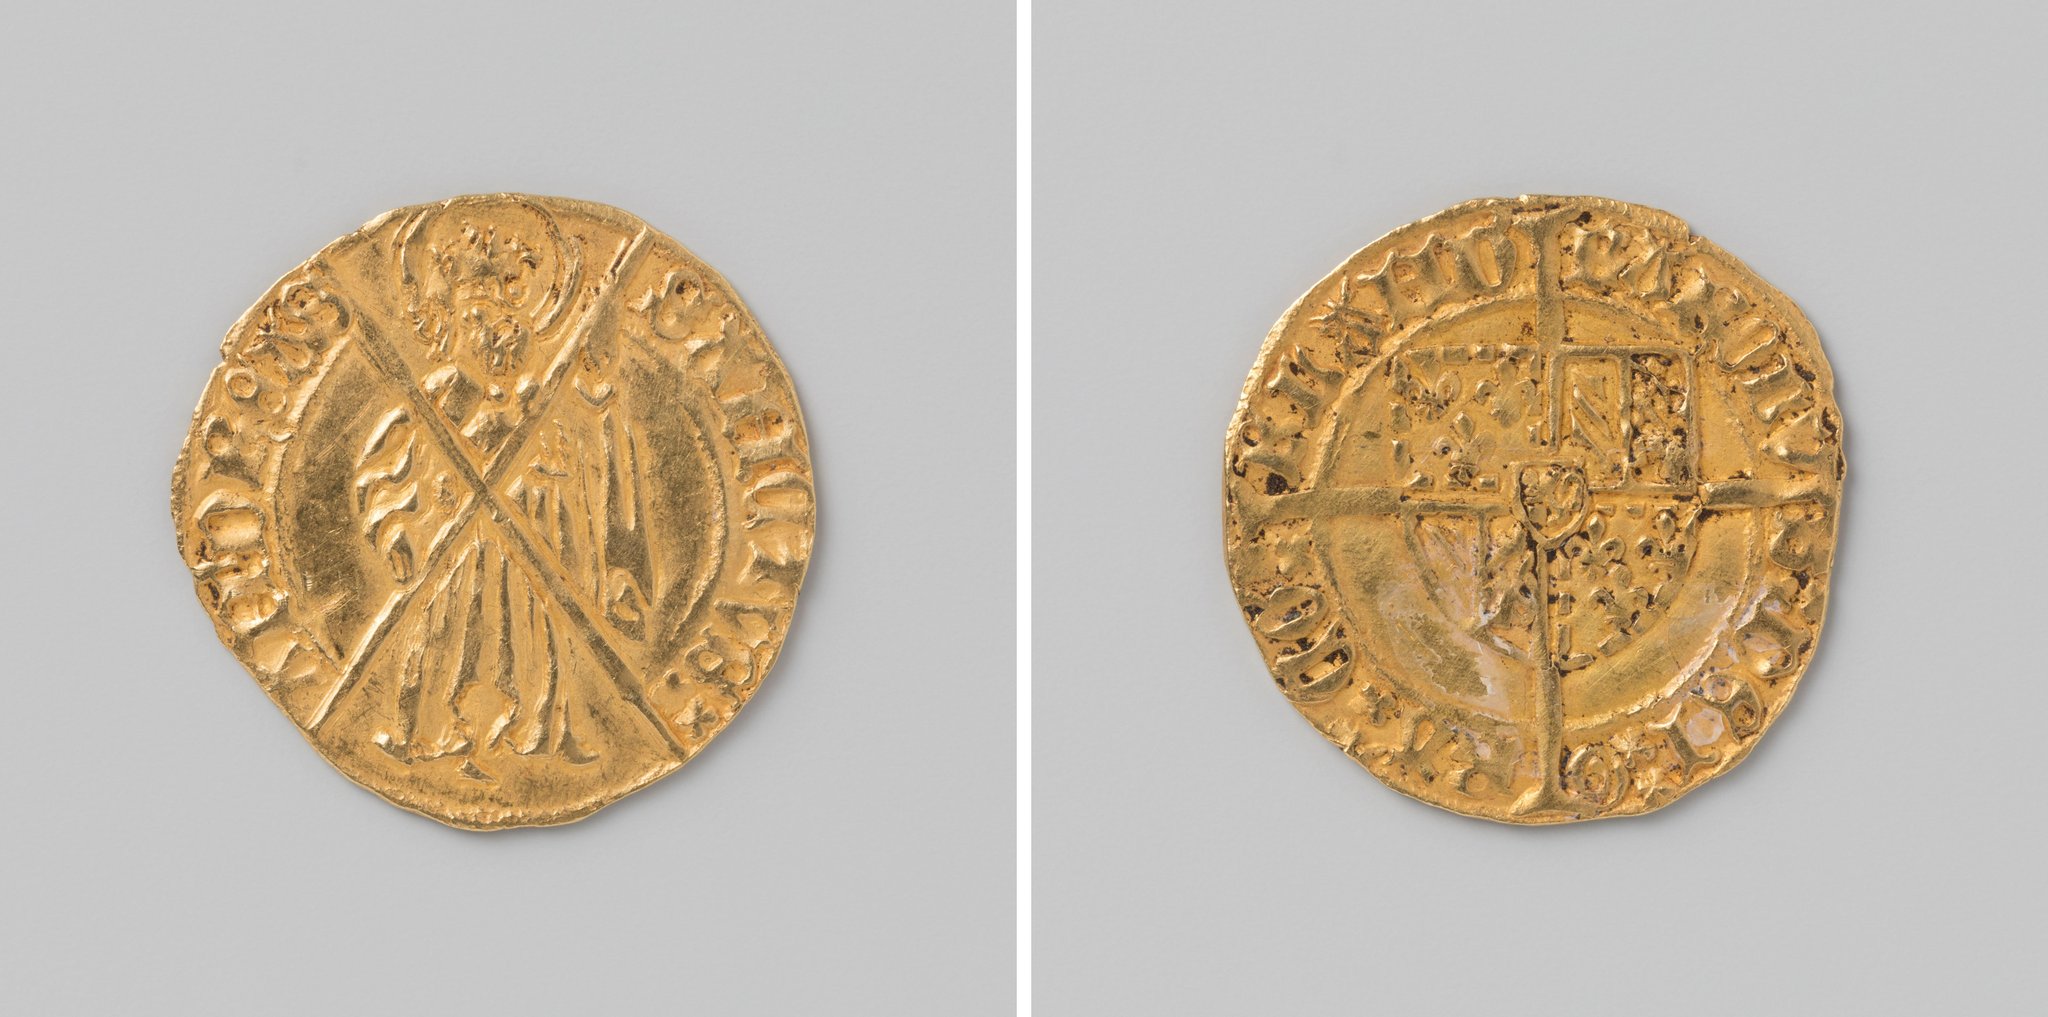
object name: coin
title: Andriesgulden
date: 1470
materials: gold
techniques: striking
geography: bruges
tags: germany, brielle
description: Opgegraven in de tuin van het in 1557 gestichte Merula-weeshuis te Brielle.